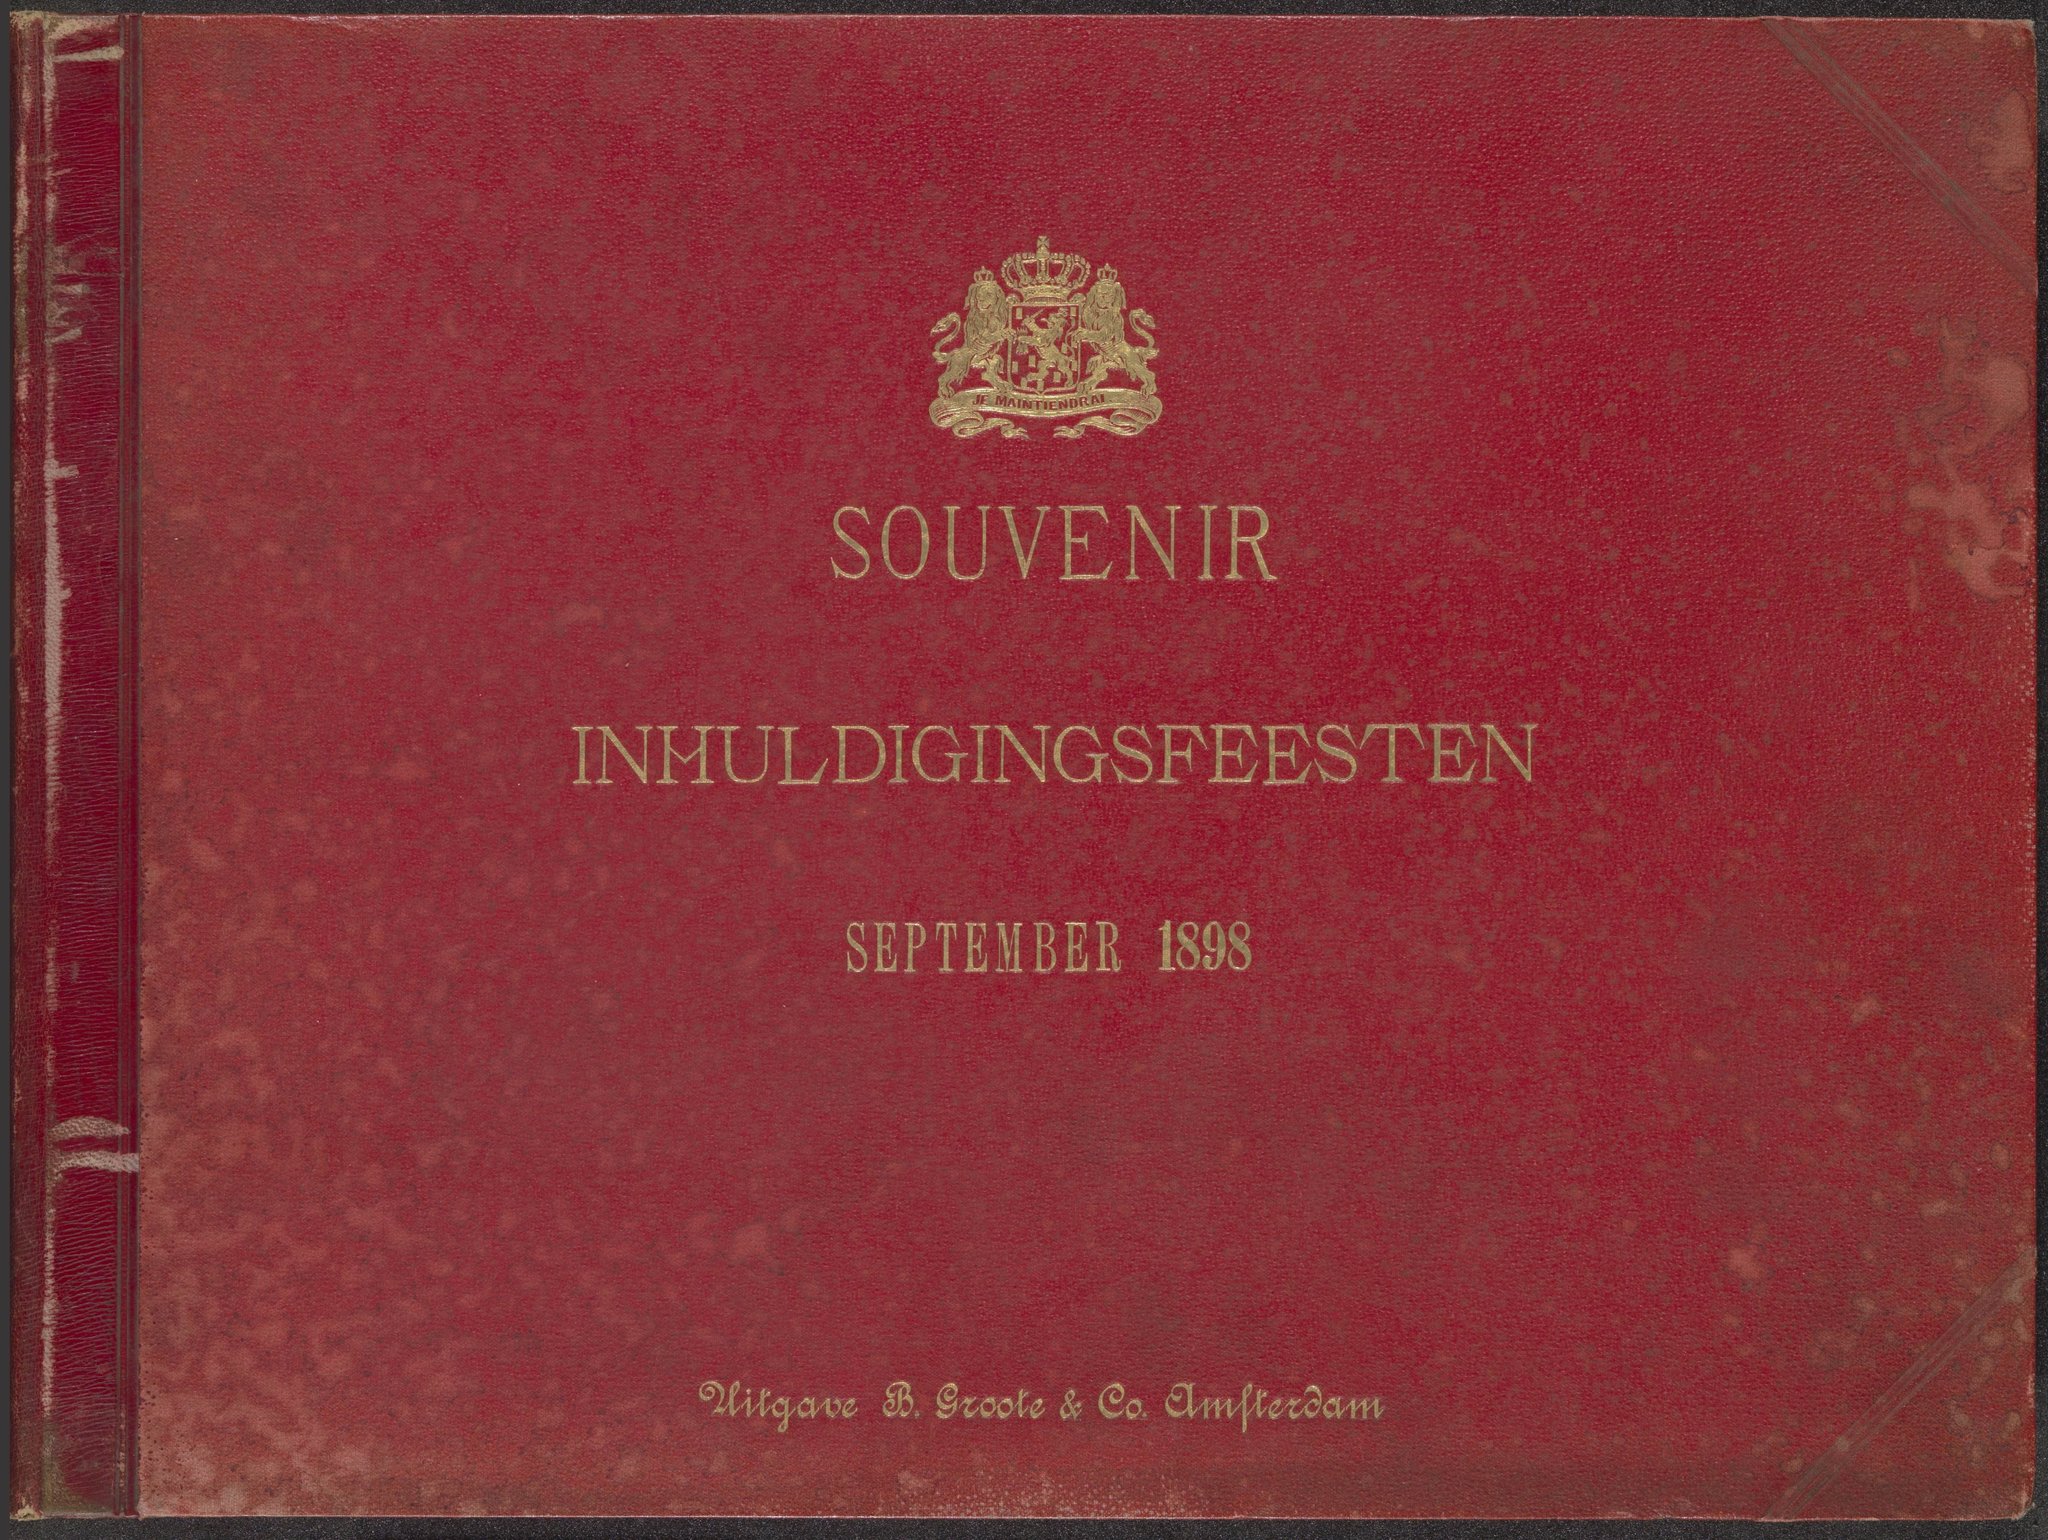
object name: photograph album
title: Souvenir Inhuldigingsfeesten september 1898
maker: barend groote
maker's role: fotograaf, fotohandel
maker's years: 1862-1946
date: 1809-1898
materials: cardboard, leather, linen, paper, photographic support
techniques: marbled paper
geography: amsterdam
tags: the hague, wilhelmina of the netherlands, ceremonial celebration of installation of a ruler, public festivities on the occasion of royal events, installation of a ruler - bb - female ruler, netherlands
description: Fotoalbum in rode band met op de voorzijde in gouddruk de titel, de naam van de uitgever en een wapenschild met daaronder de spreuk 'Je maintiendrai'. De albumrug is van leer. De schutbladen hebben een patroon van schaduwmarmer in blauw en zwart. Het album bevat vijftien kartonnen bladen met evenveel foto's. Het betreft opnames van de inhuldiging van Wilhelmina als koningin in september 1898 en van festiviteiten die in dit kader werden gehouden.